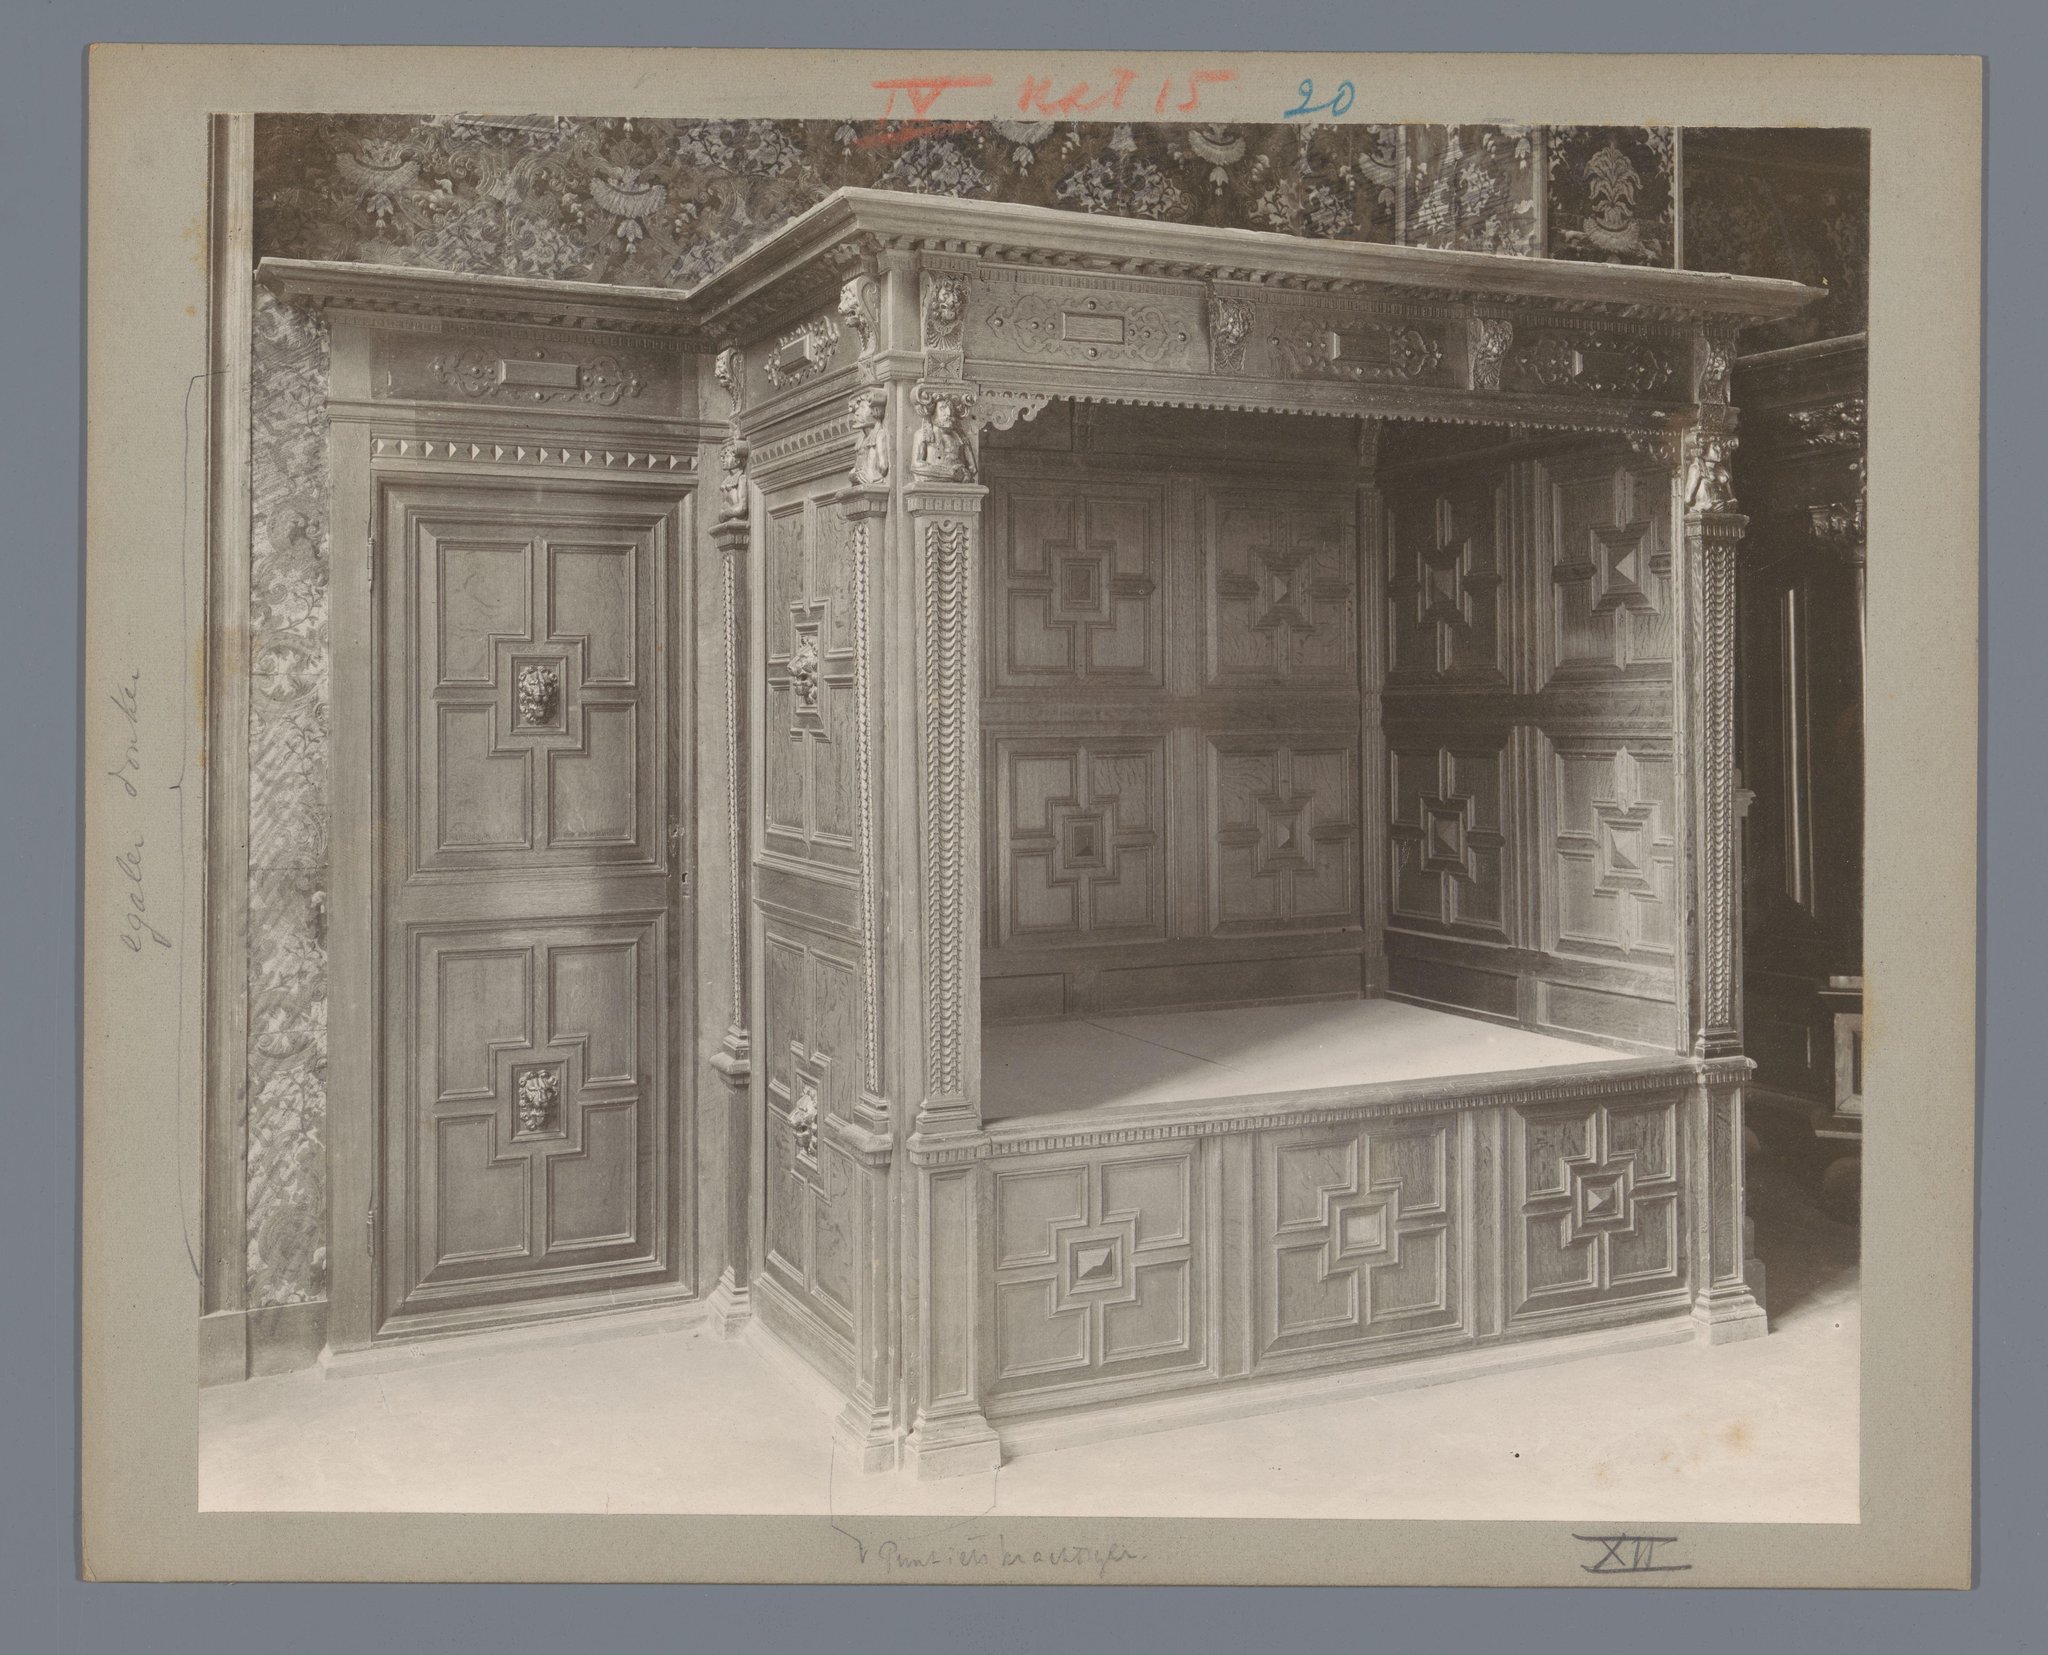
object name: photograph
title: Bedstede (vermoedelijk) in het Rijksmuseum te Amsterdam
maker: Anonymous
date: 1875-1900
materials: paper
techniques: carbon print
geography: amsterdam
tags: built-in bedstead (dutch: 'bedstee')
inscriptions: collector's mark: ‘Kunstnijverheidschool Quellinus Amsterdam Frans Halsstraat 14.’, collector's mark: ‘Instituut voor kunst-nijverheidsonderwijs Gabriël Metsustraat No. 16, Amsterdam’